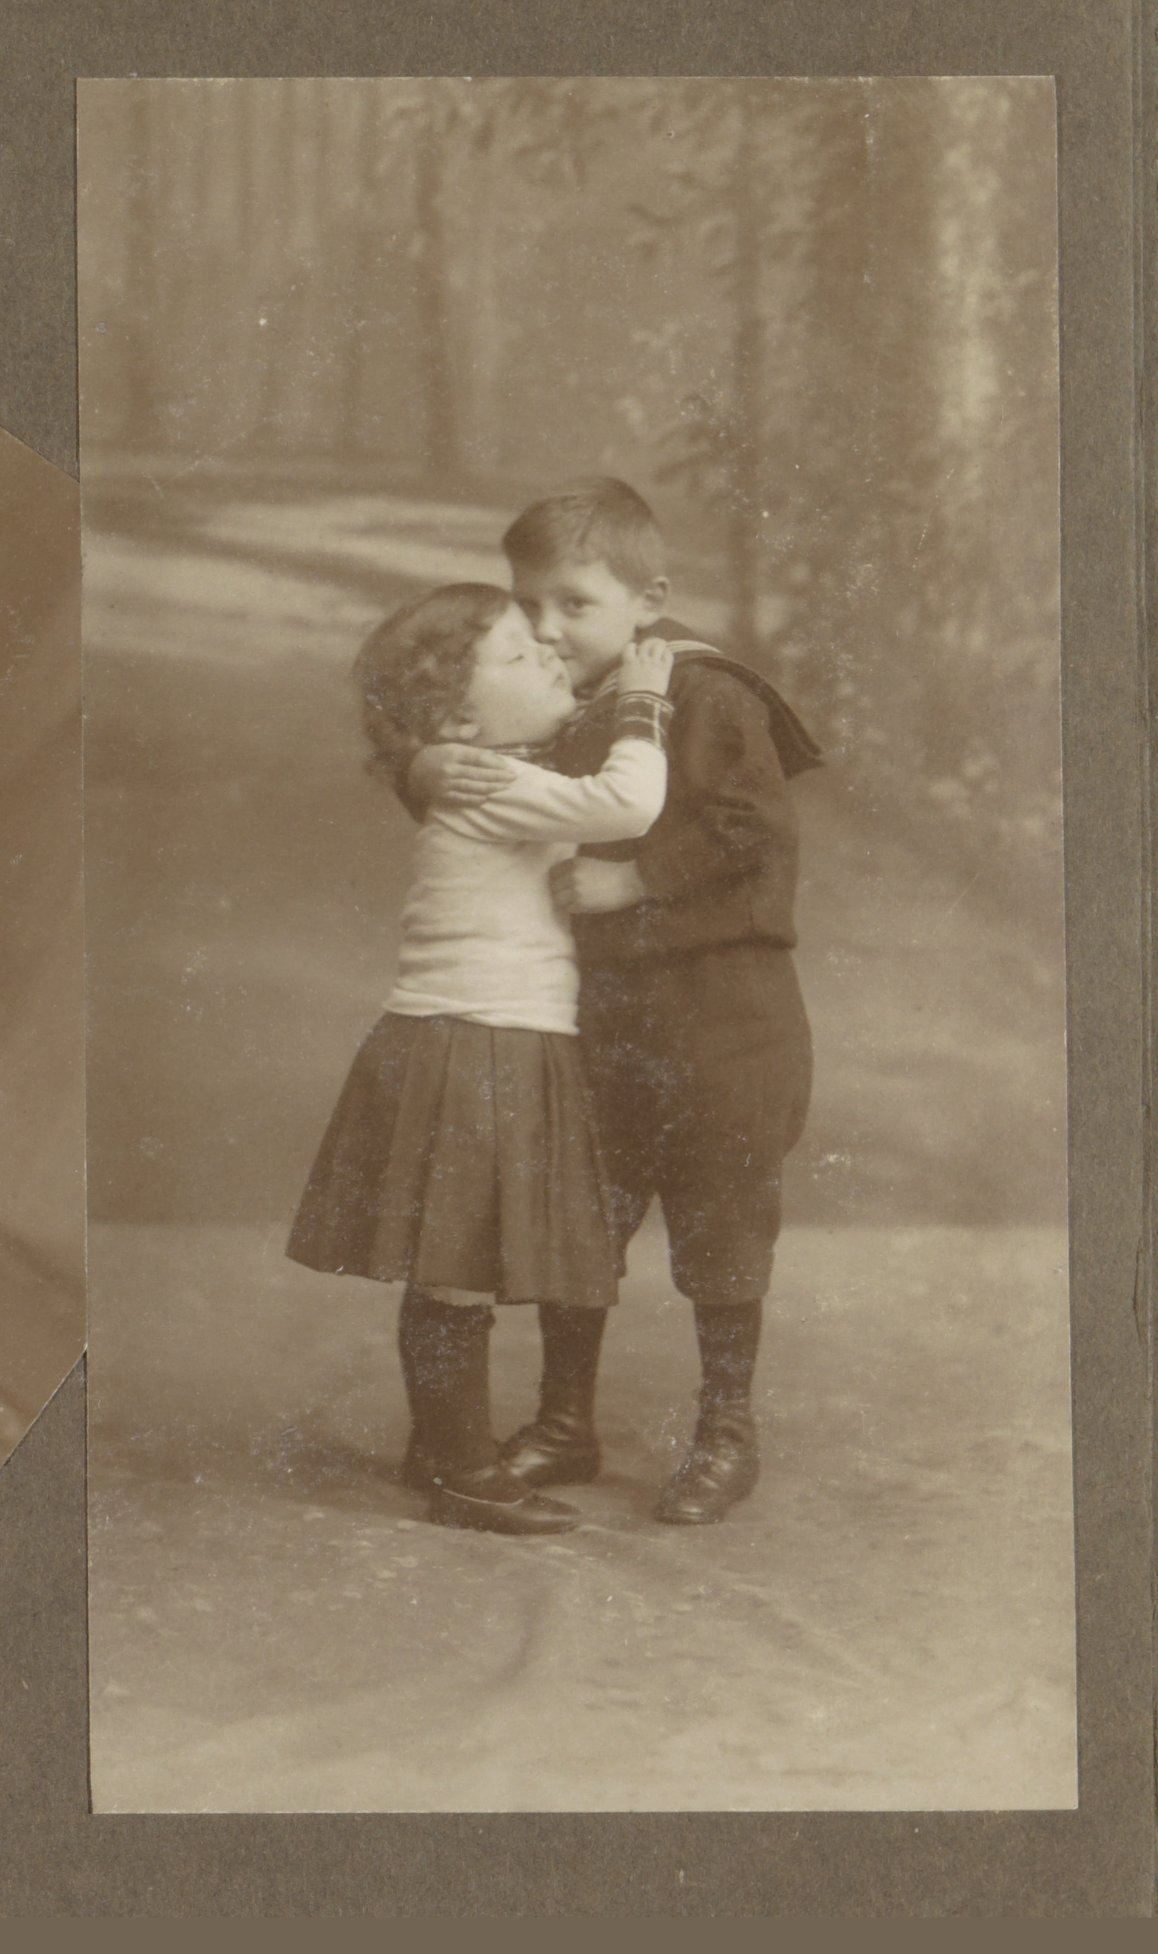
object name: photograph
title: Portret van twee kinderen Vermeulen, elkaar kussend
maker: cornelis johannes lodewicus vermeulen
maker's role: fotograaf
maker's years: 1861-1936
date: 1900-1920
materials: paper, photographic support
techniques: gelatin silver print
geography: the hague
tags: embracing each other, kissing, brothers or sisters (second degree family relationships), the hague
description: Onderdeel van Fotoalbum met opnames van het gezin en het huis van fotograaf C.J.L. Vermeulen in Den Haag.